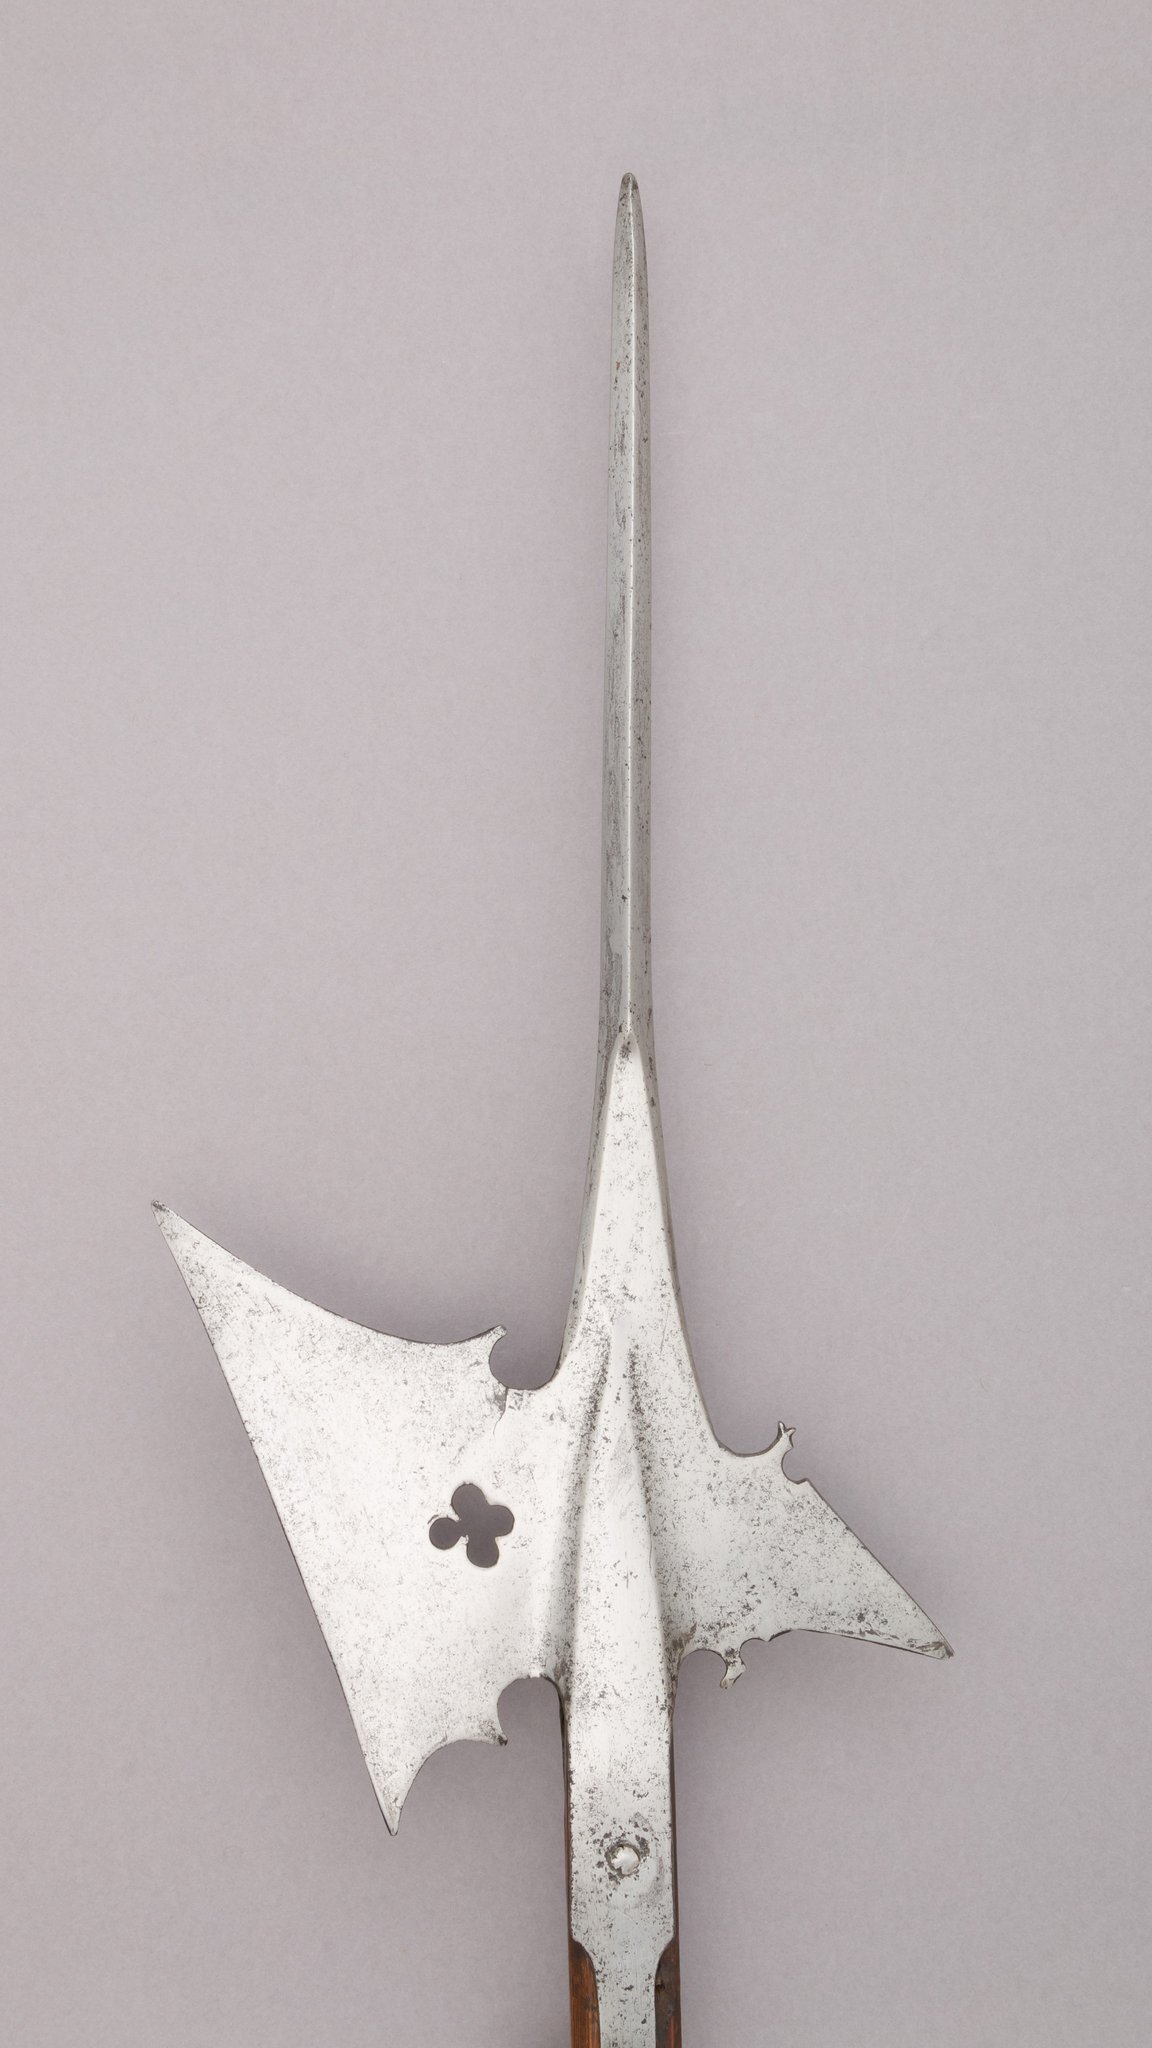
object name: halberd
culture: german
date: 1501-1533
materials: steel, wood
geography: germany